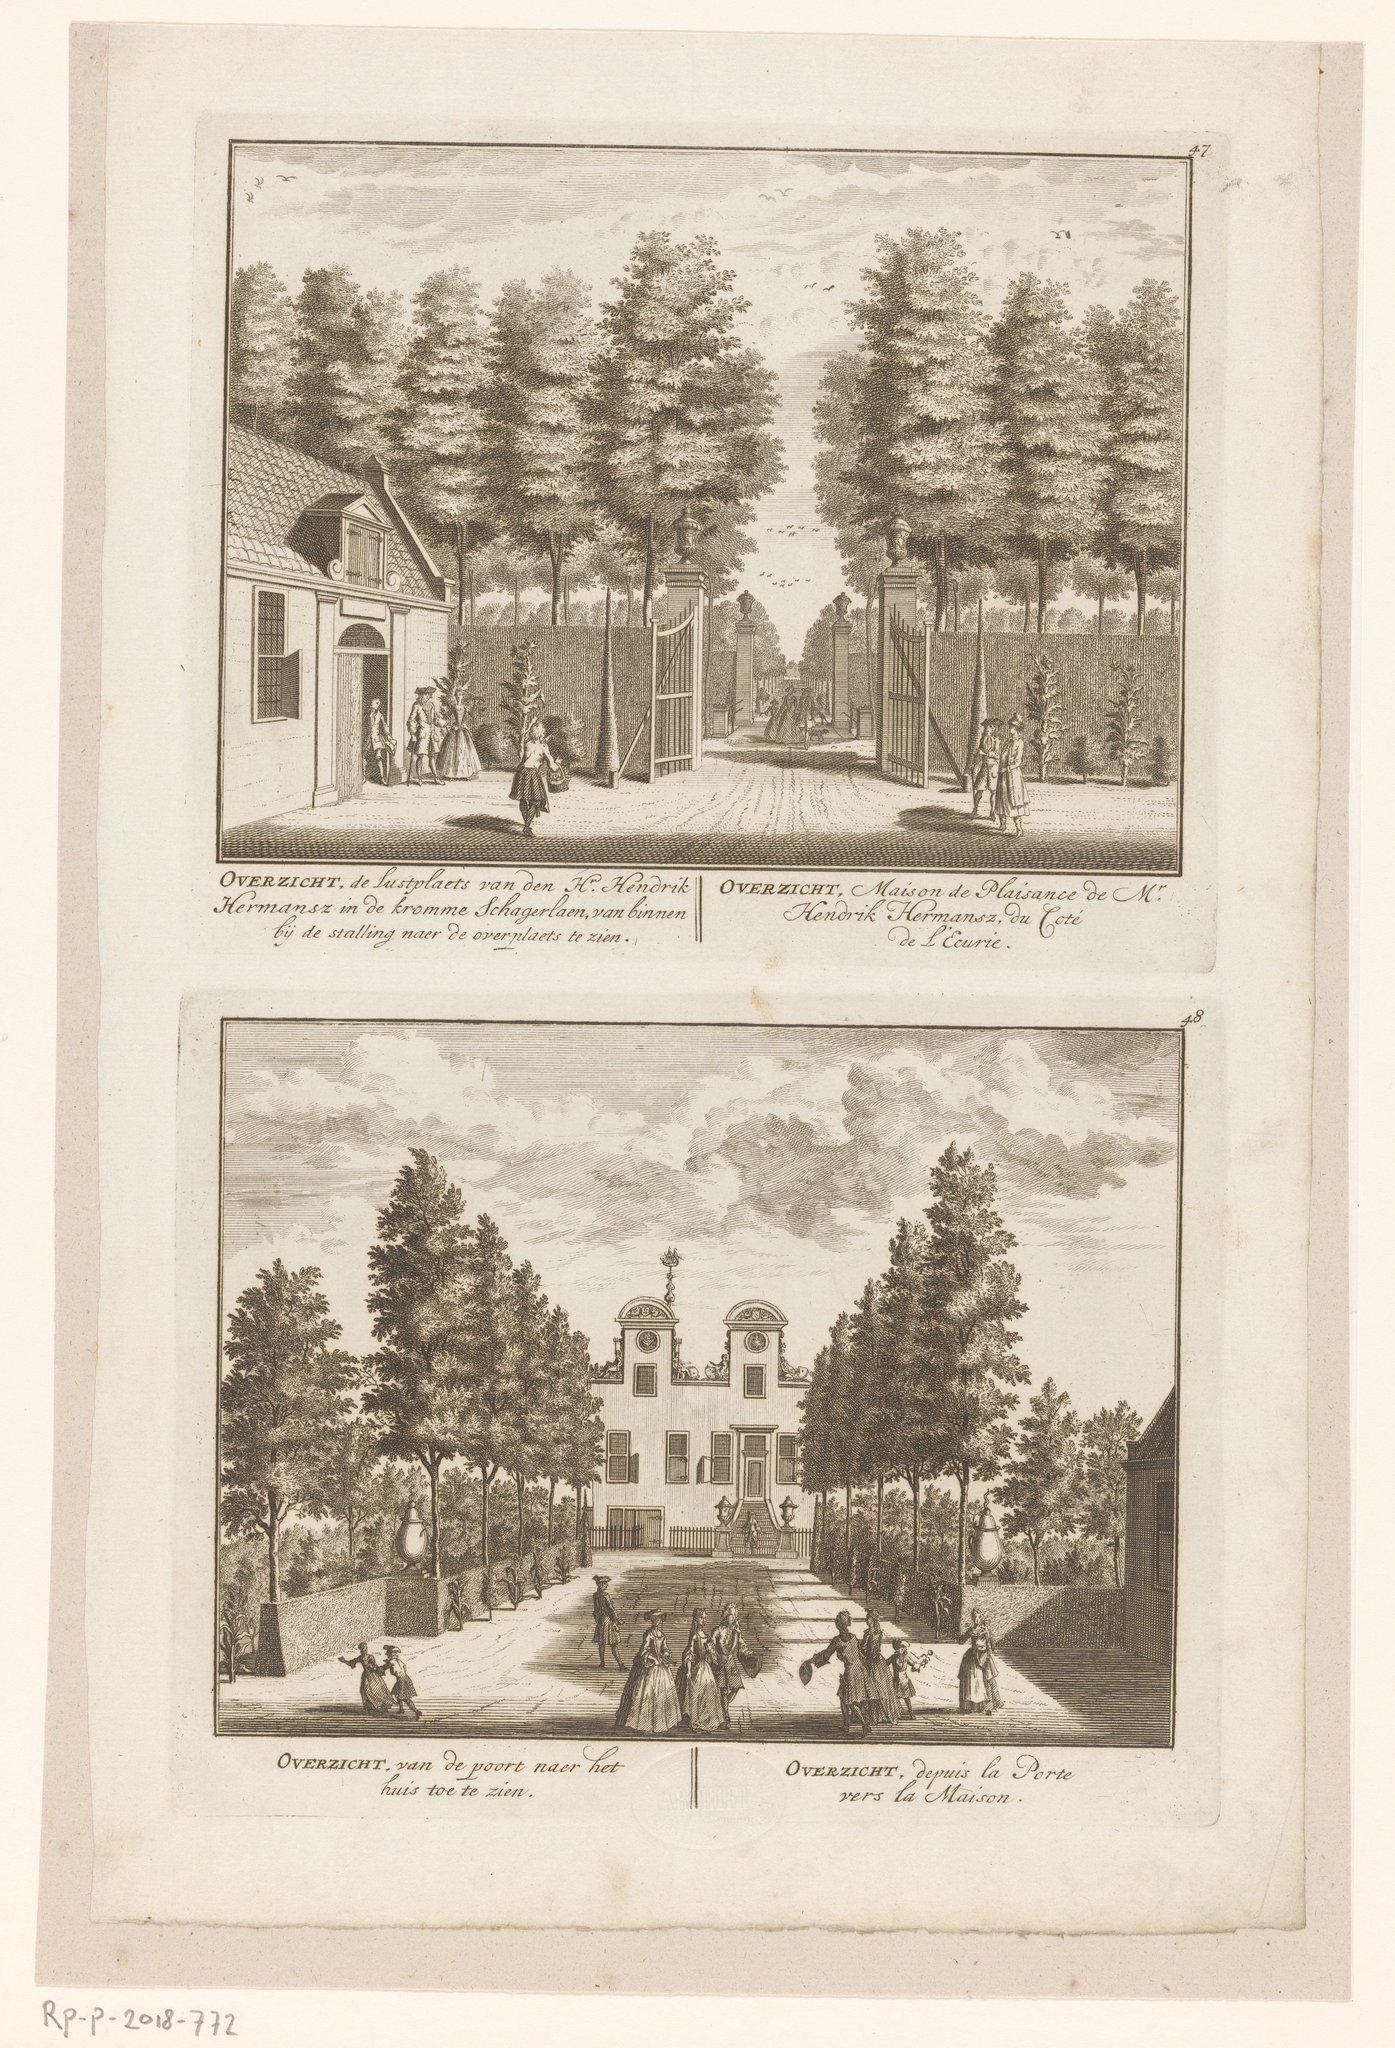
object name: print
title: Overzicht, de lustplaets van den hr. Hendrik Hermansz in de (...) / Overzicht, maison de plaisance de mr. Hendrik Hermansz (...)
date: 1725-1768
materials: paper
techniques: engraving, etching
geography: amsterdam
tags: french or architectonic garden; formal garden, garden pond, hotel, hostelry, inn, country-house, amsterdam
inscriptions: check stamp: ‘Archief Ministerie van Oorlog Afdeeling Genie’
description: Prent gebruikt in: Niedek, Mattaeus Brouërius. Het verheerlykt Watergraafs- of Diemermeer by de stadt Amsterdam (...). Amsterdam: Andries en Hendrik de Leth, 1725. Of in: Niedek, Mattaeus Brouërius. Het verheerlykt Watergraafs- of Diemermeer by de stadt Amsterdam (...). Amsterdam: Pieter Jan Entrop, 1768.